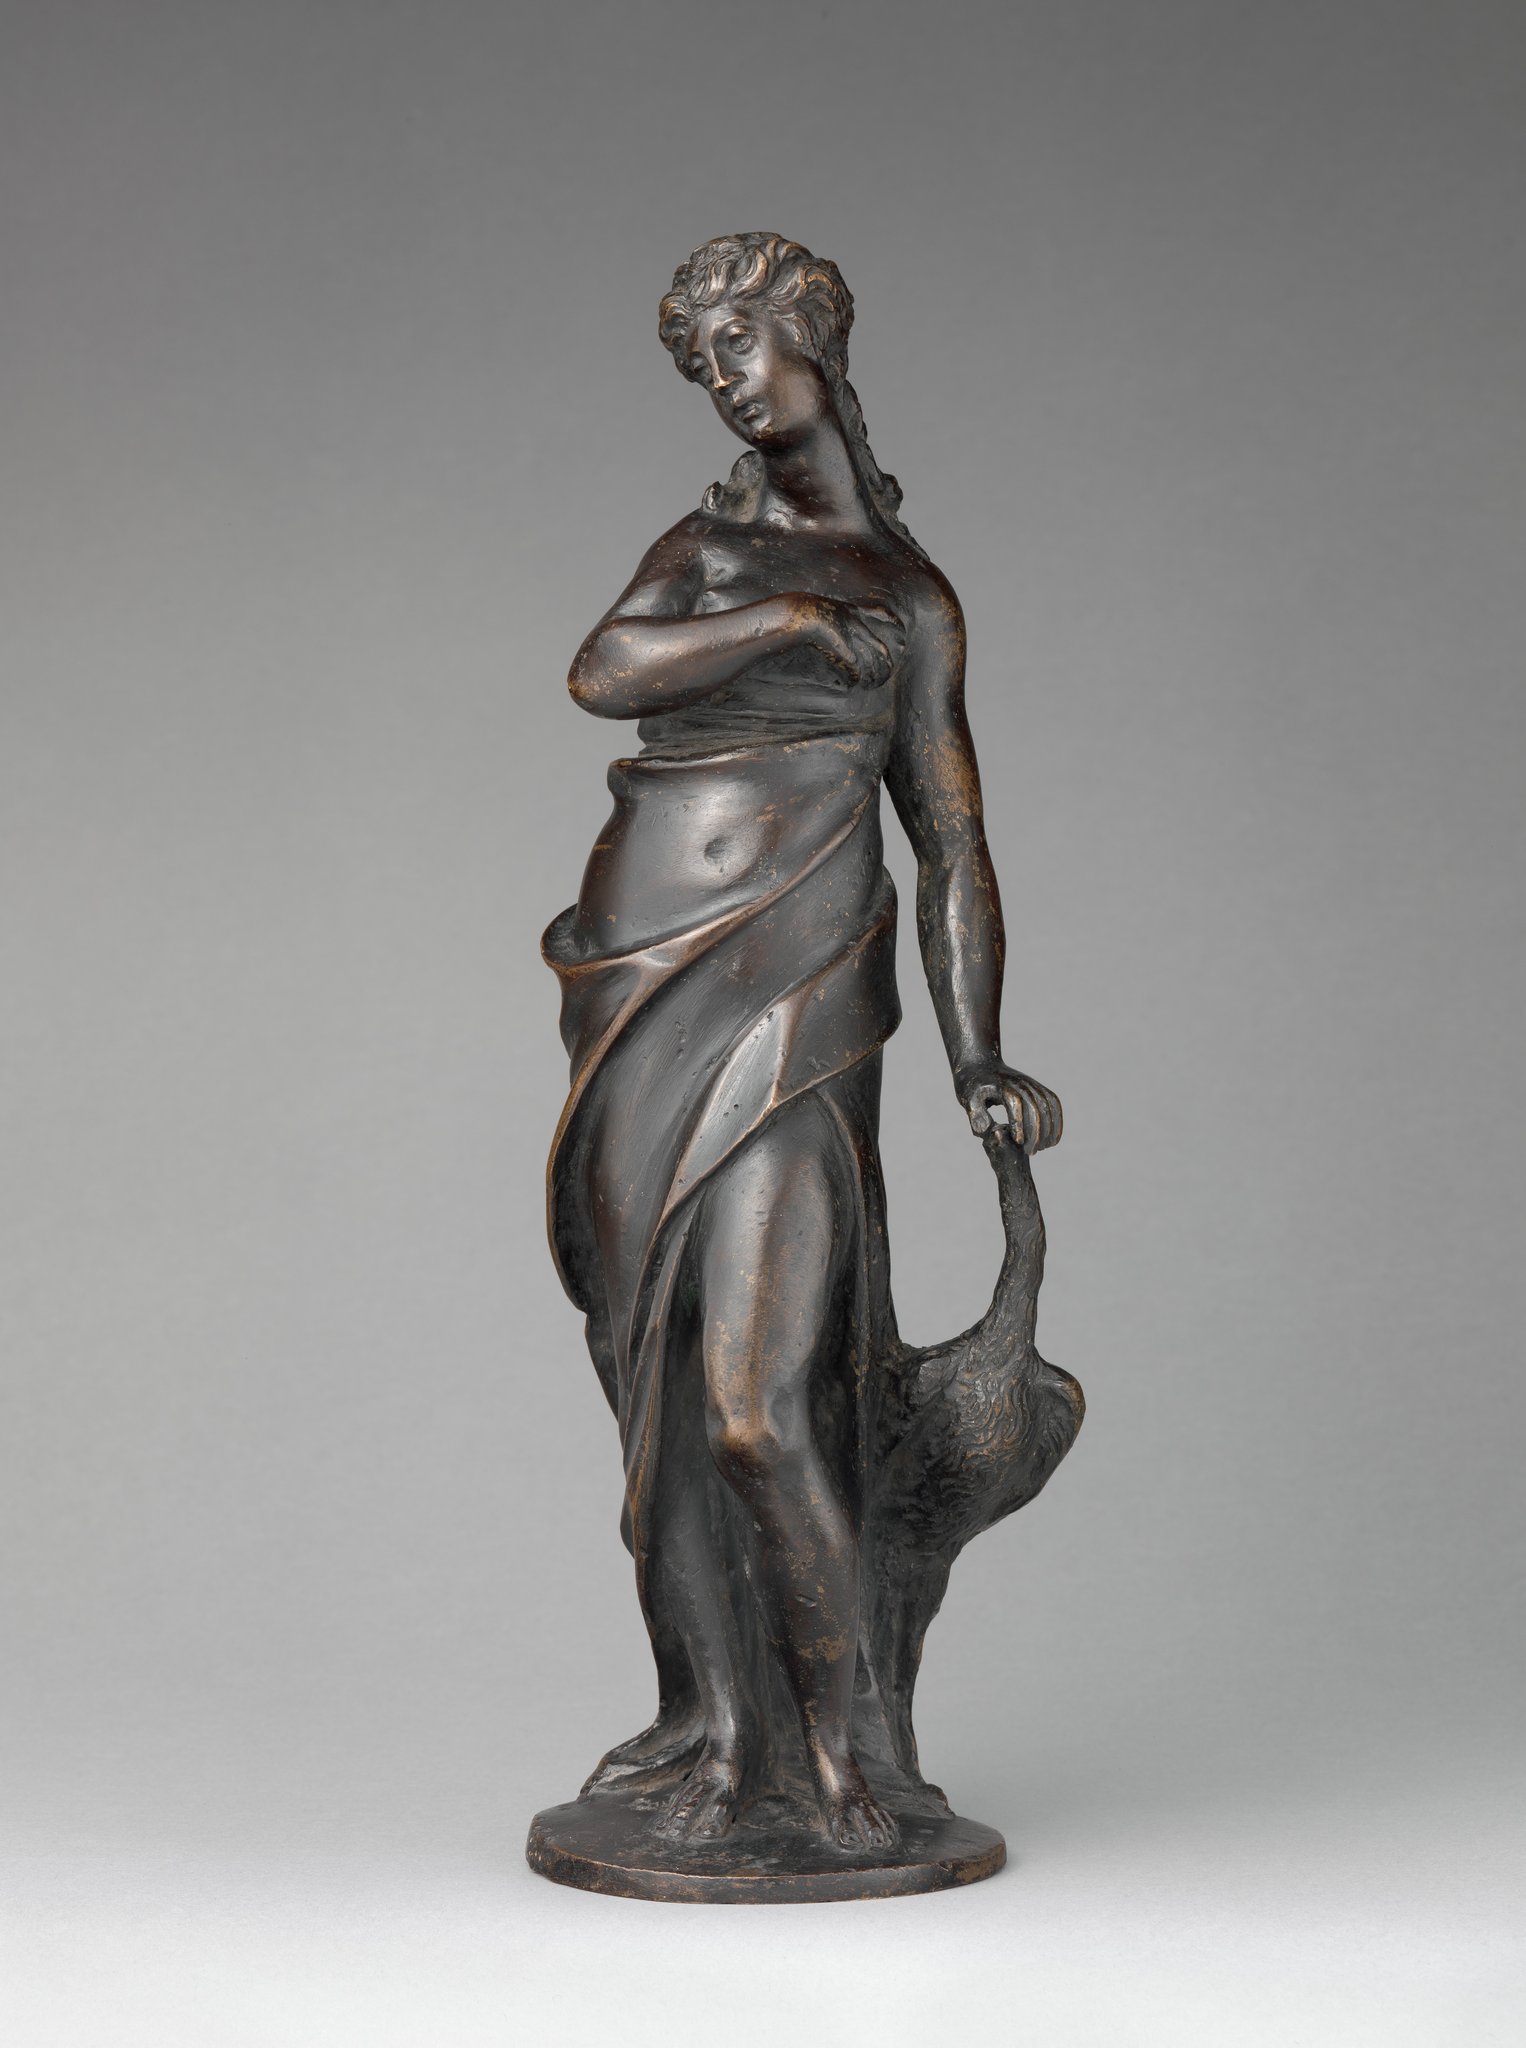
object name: statuette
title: Juno and the peacock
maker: alessandro vittoria (alessandro vittoria di vigilio della volpa)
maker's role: artist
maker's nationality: italian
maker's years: 1525-1608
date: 1567-1600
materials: bronze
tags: juno,peacocks